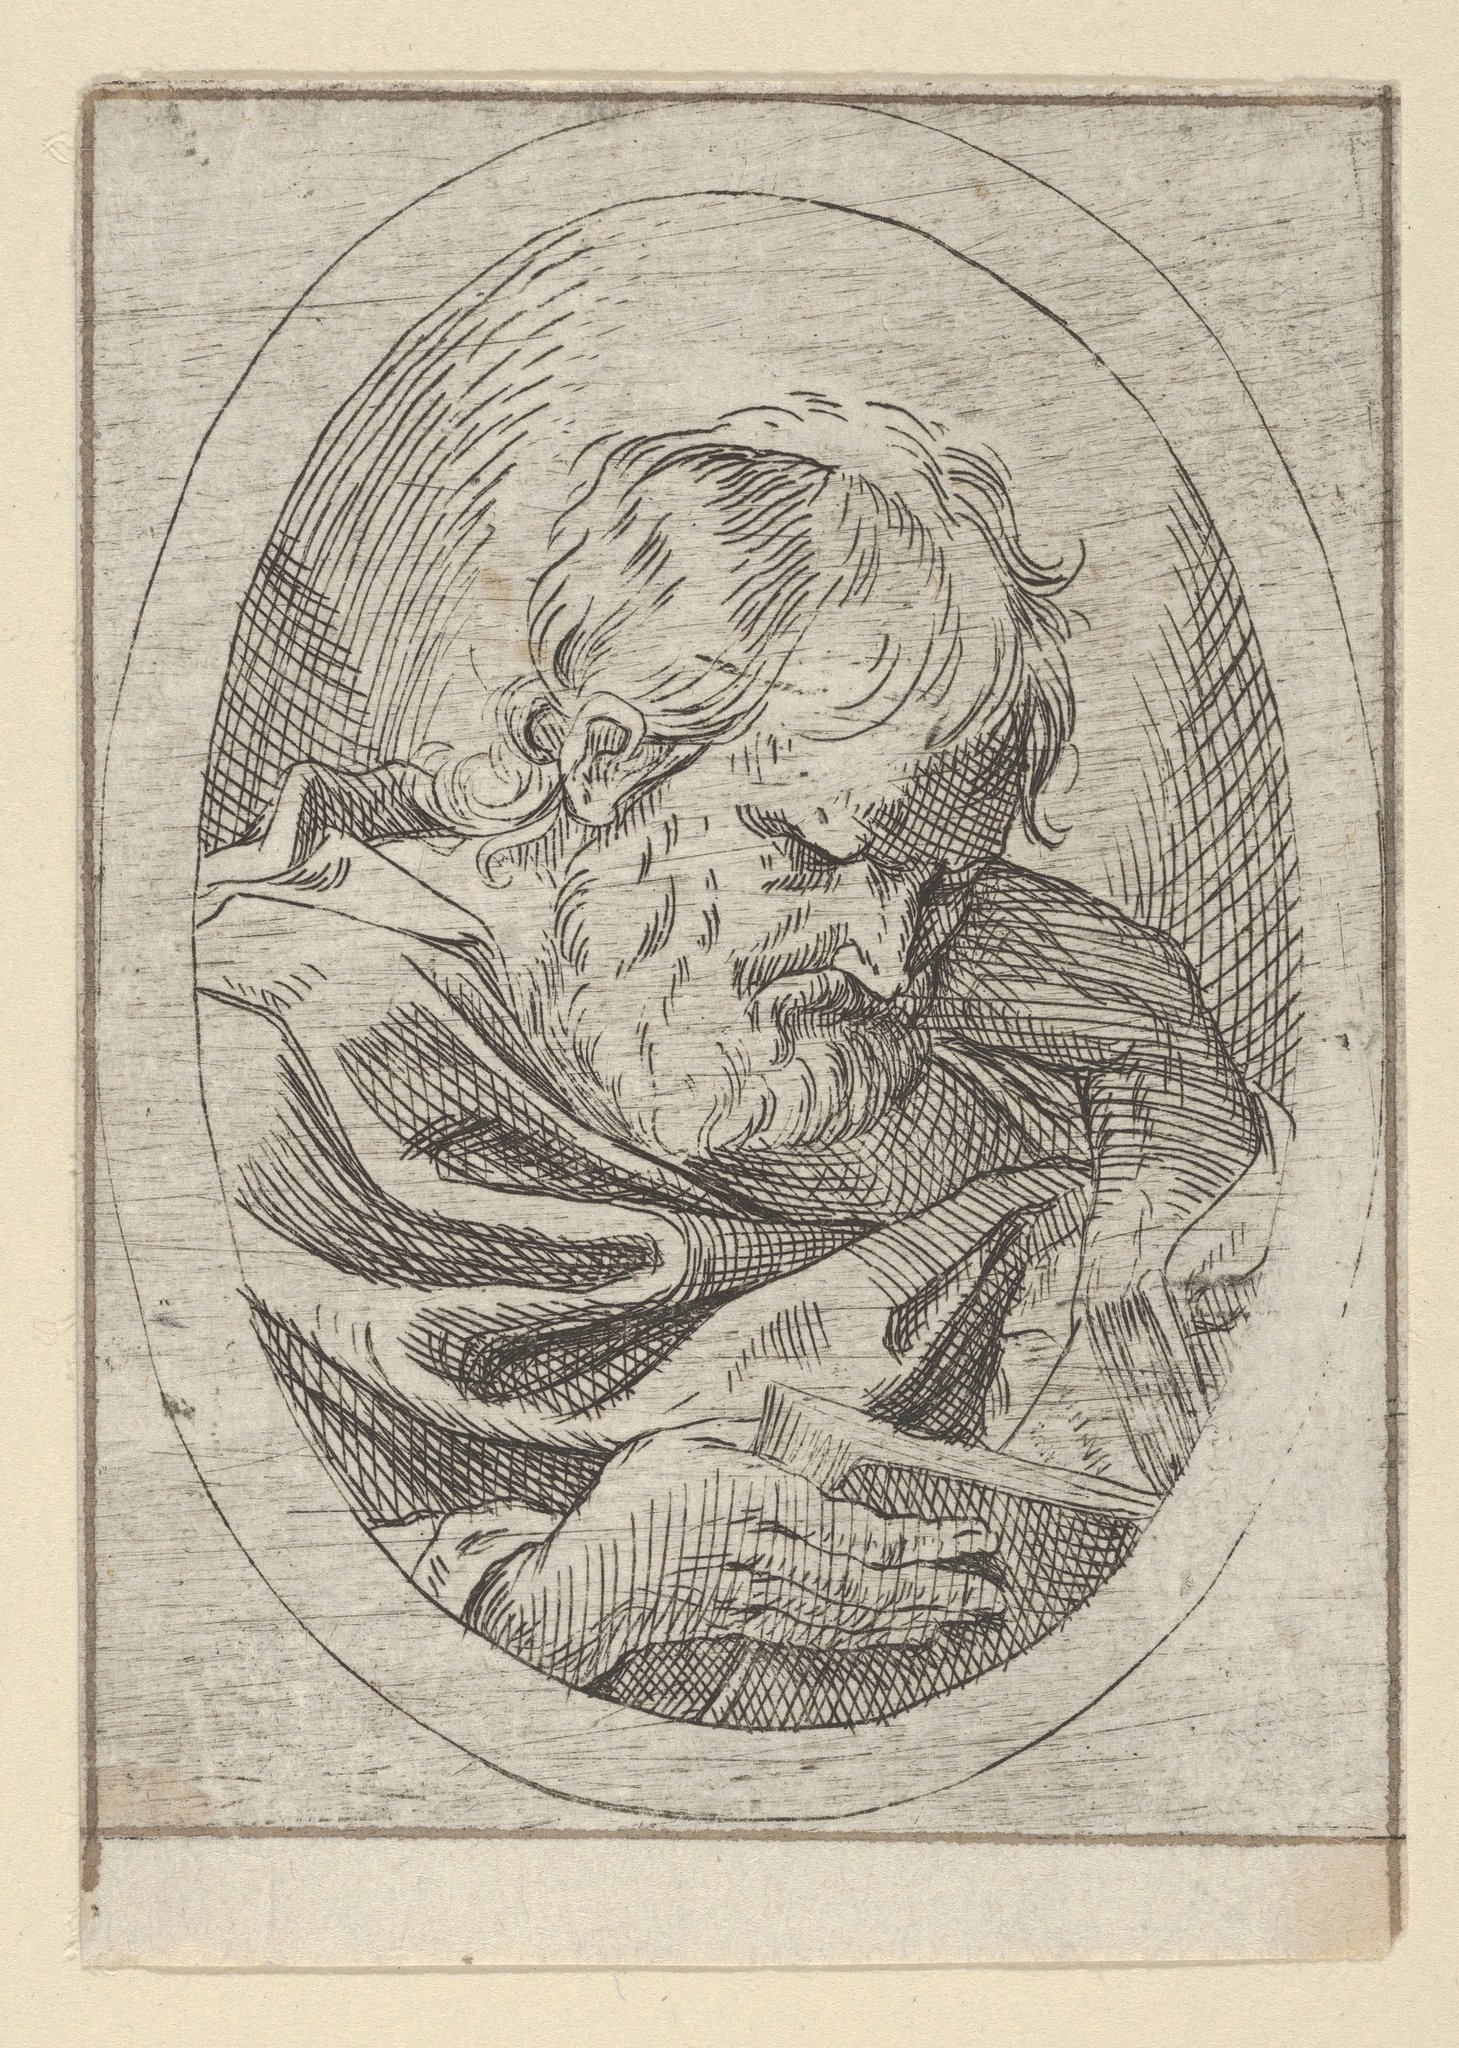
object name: print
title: An apostle resting his head on his left hand and reading a book, in an oval frame, from "Christ, the Virgin, and Thirteen Apostles"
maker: anonymous, 17th century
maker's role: artist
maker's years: 1600-1700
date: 1600-1640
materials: ink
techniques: etching, pen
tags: reading,apostles